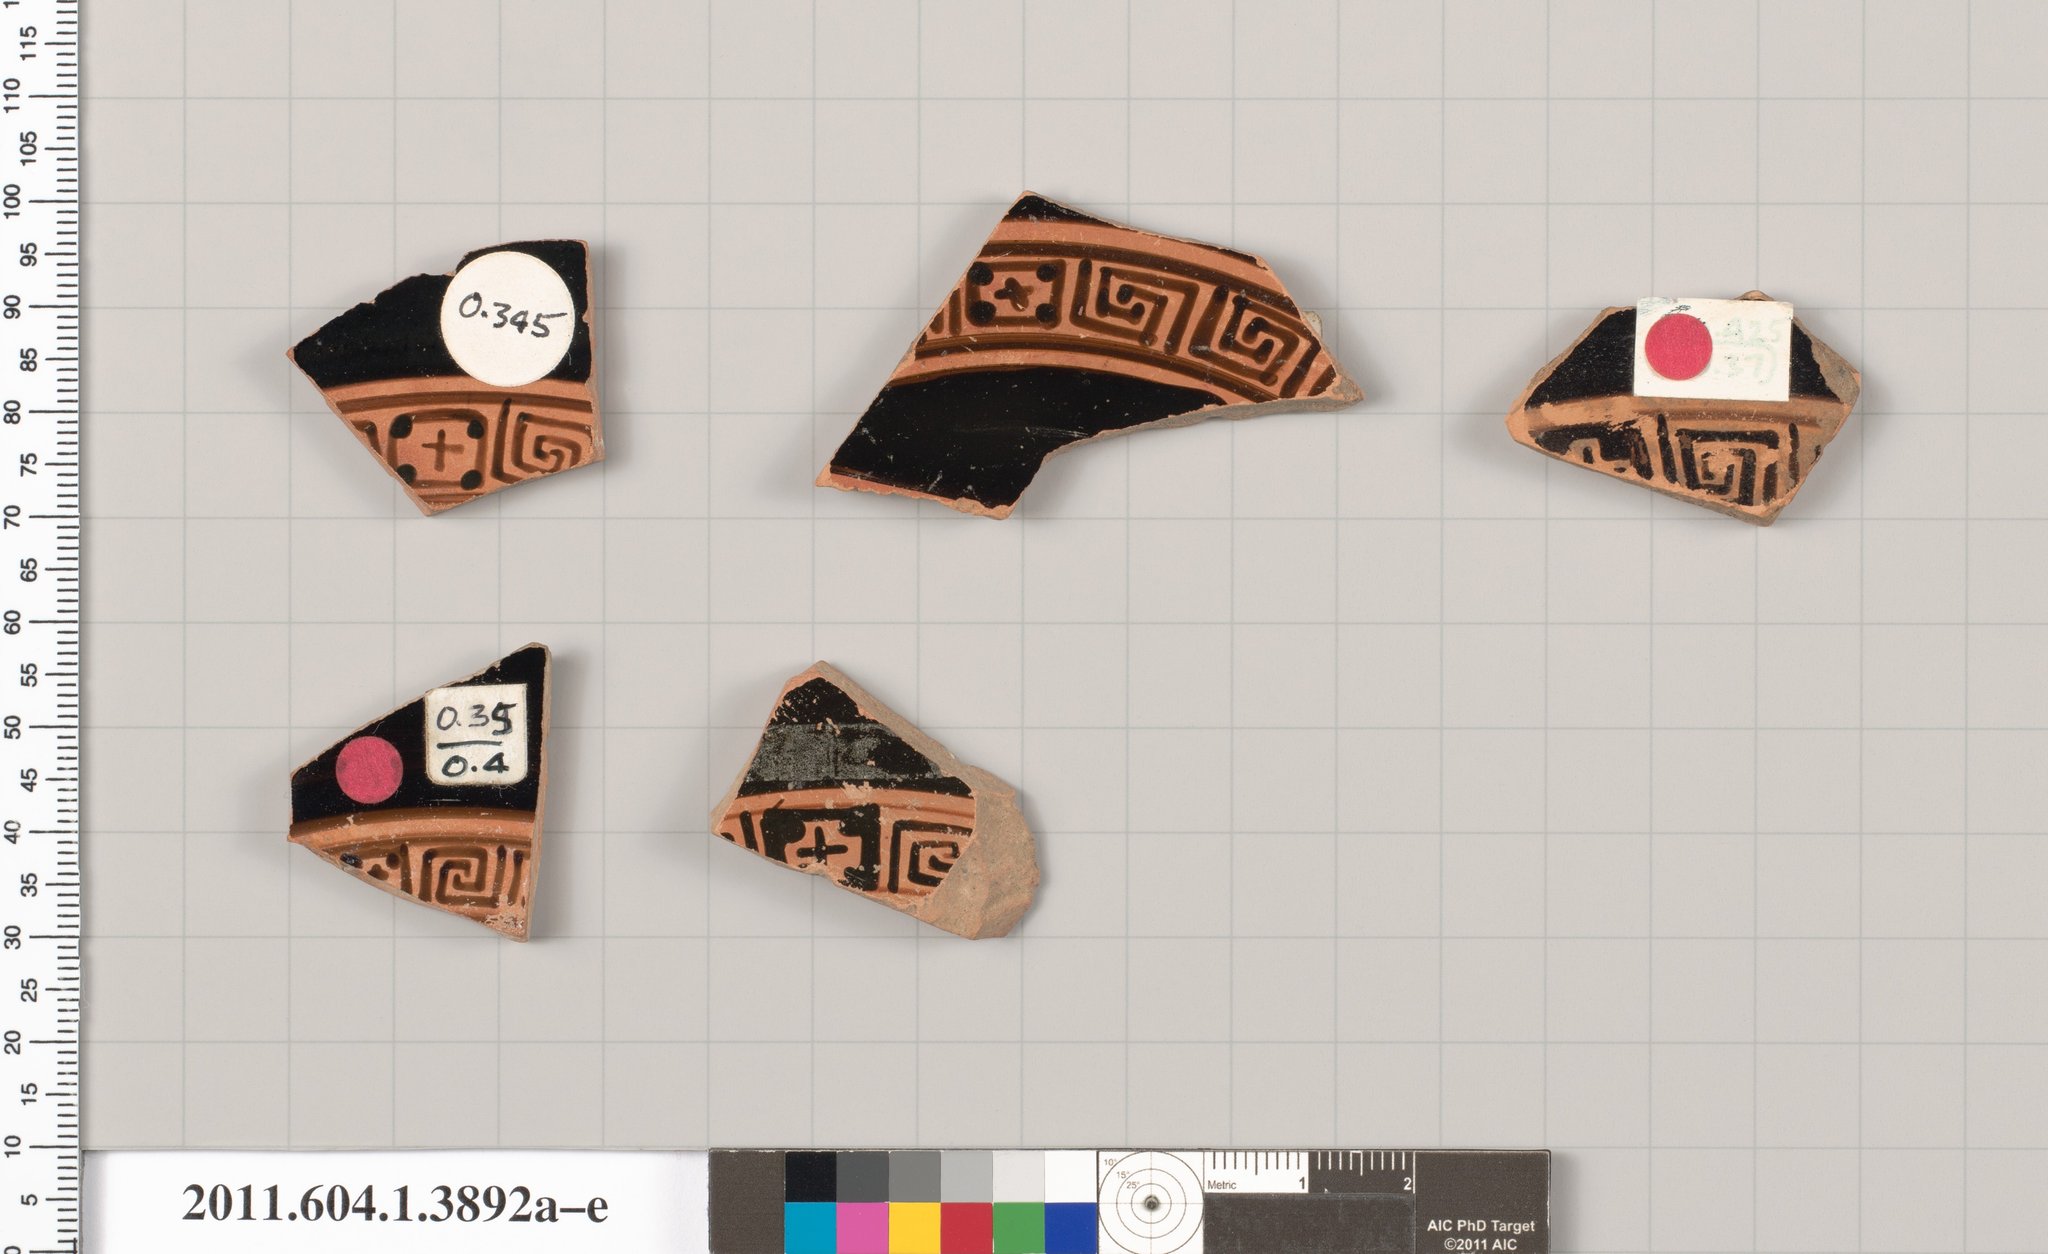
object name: kylix fragment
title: Terracotta fragments of kylikes (drinking cups)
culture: greek, attic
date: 475-451 BCE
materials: terracotta